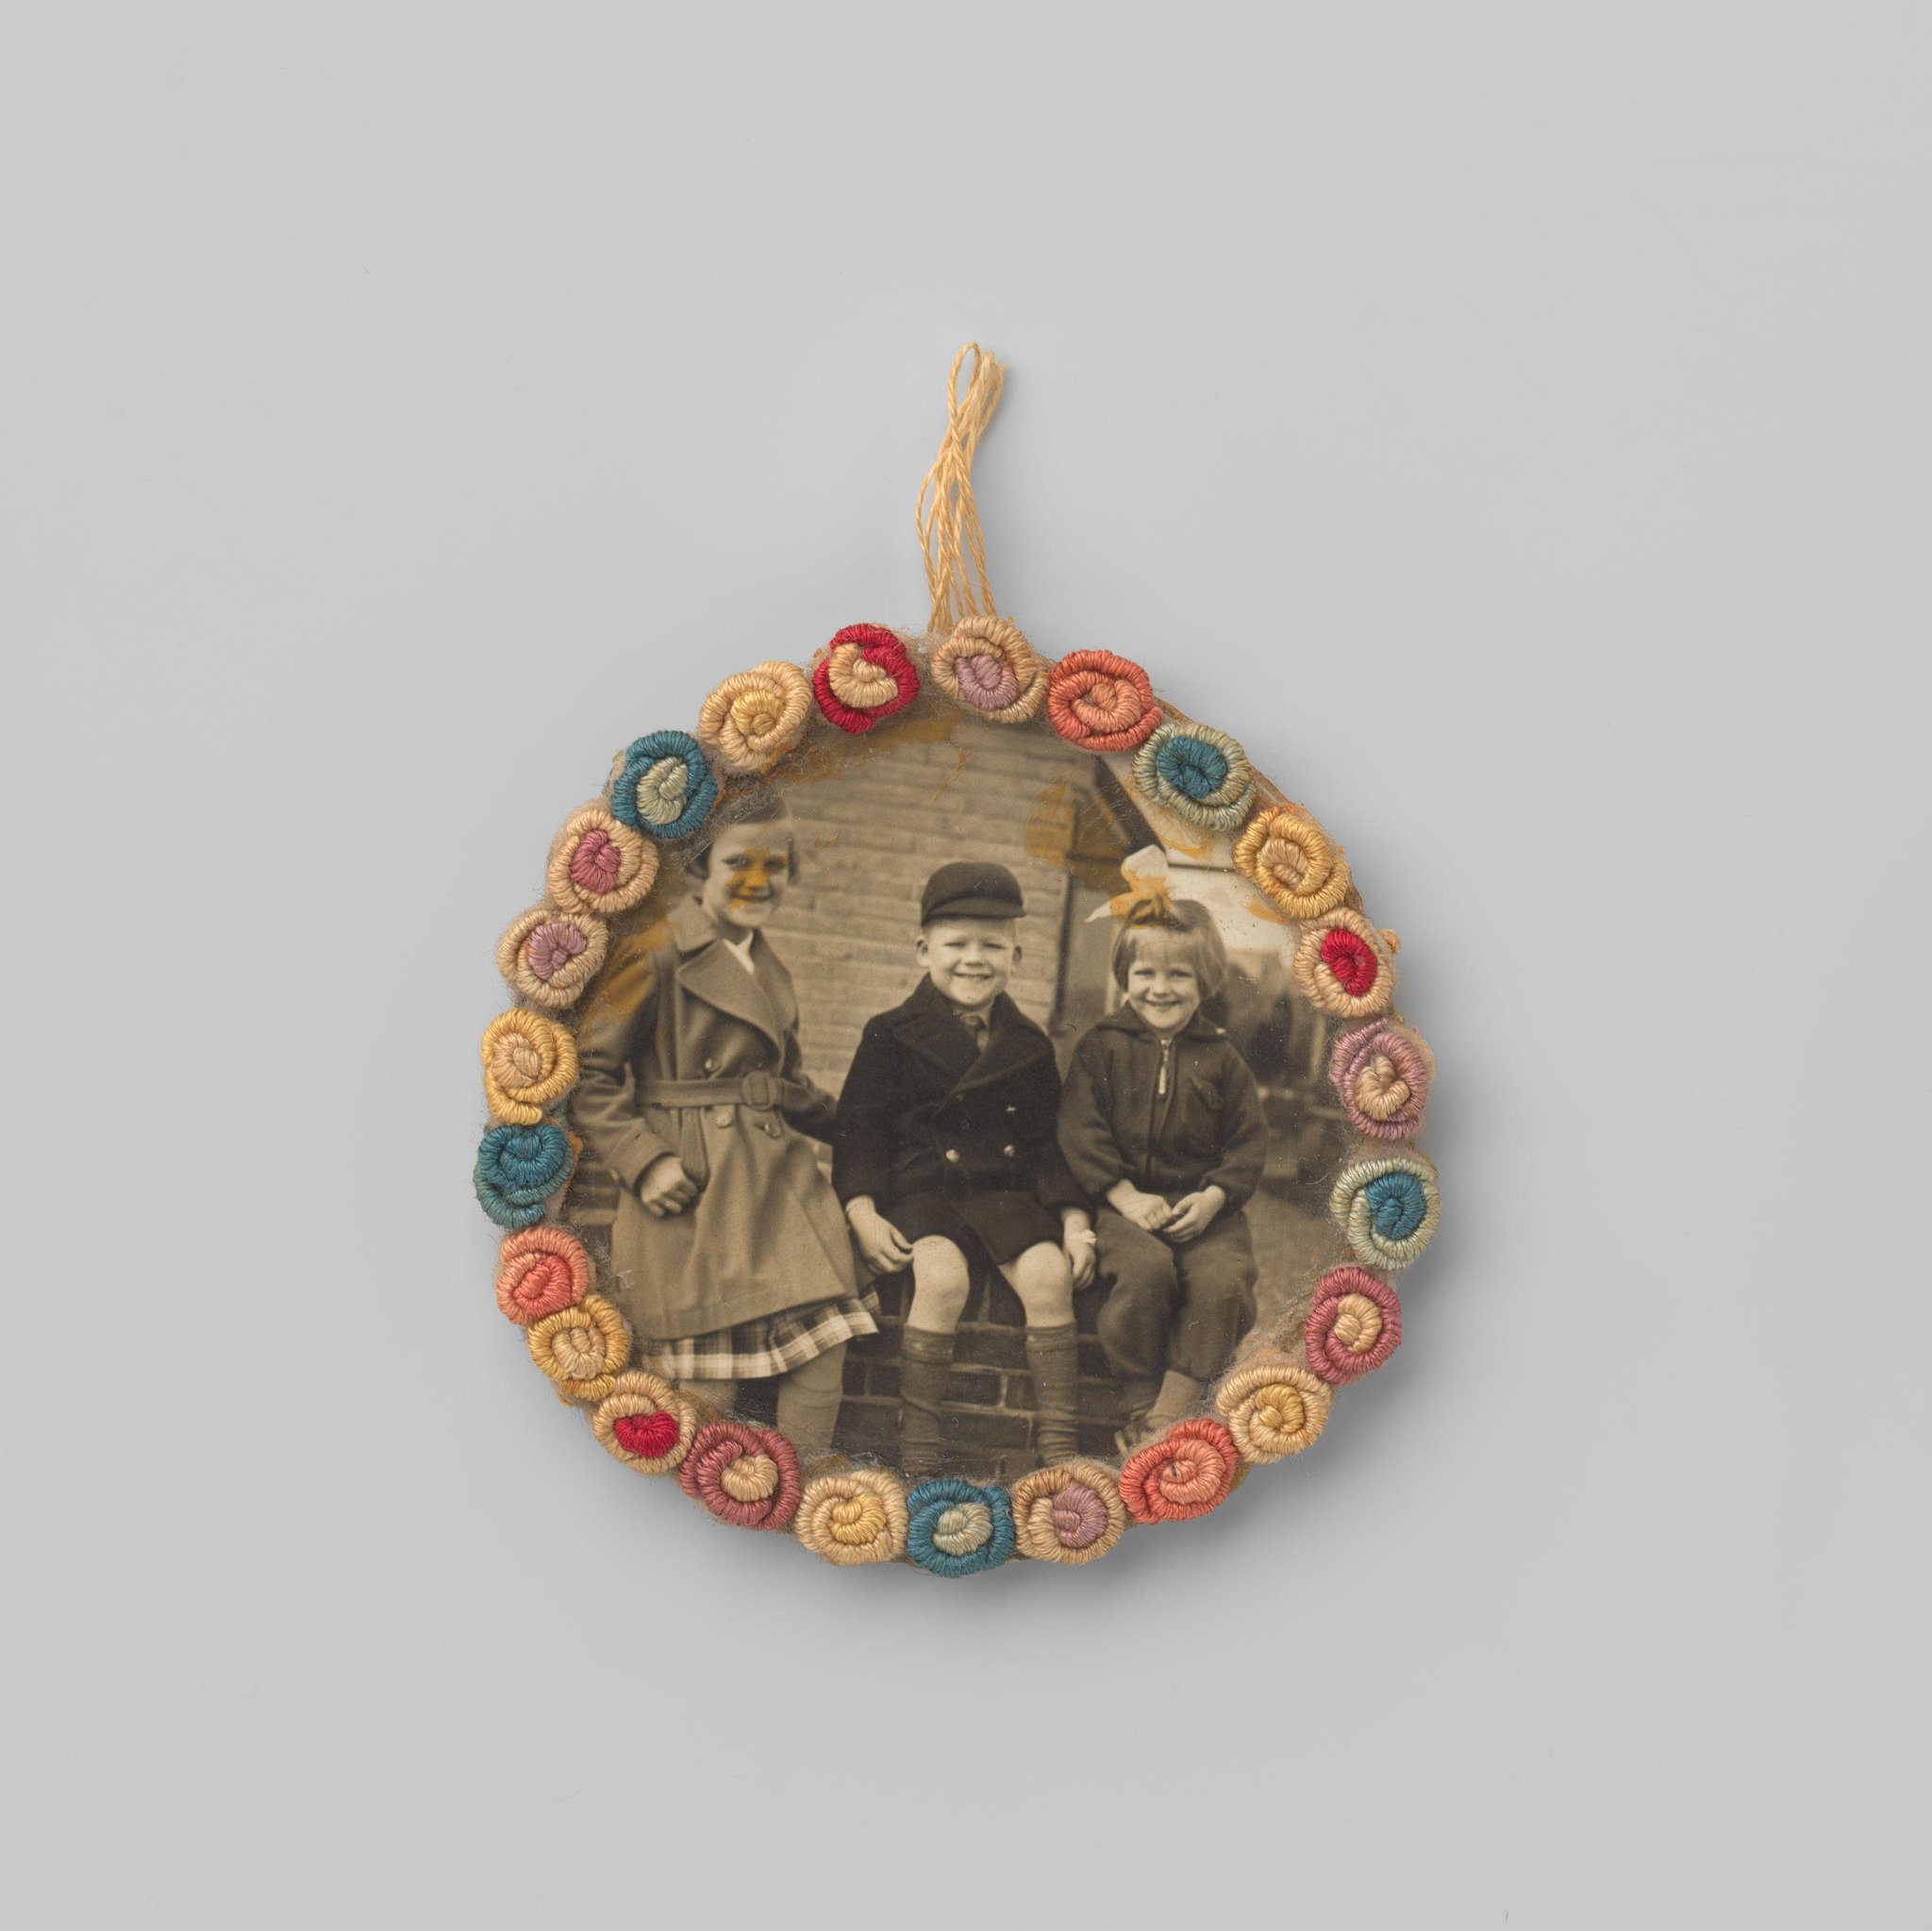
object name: locket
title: Medaillon met foto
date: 1944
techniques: photography